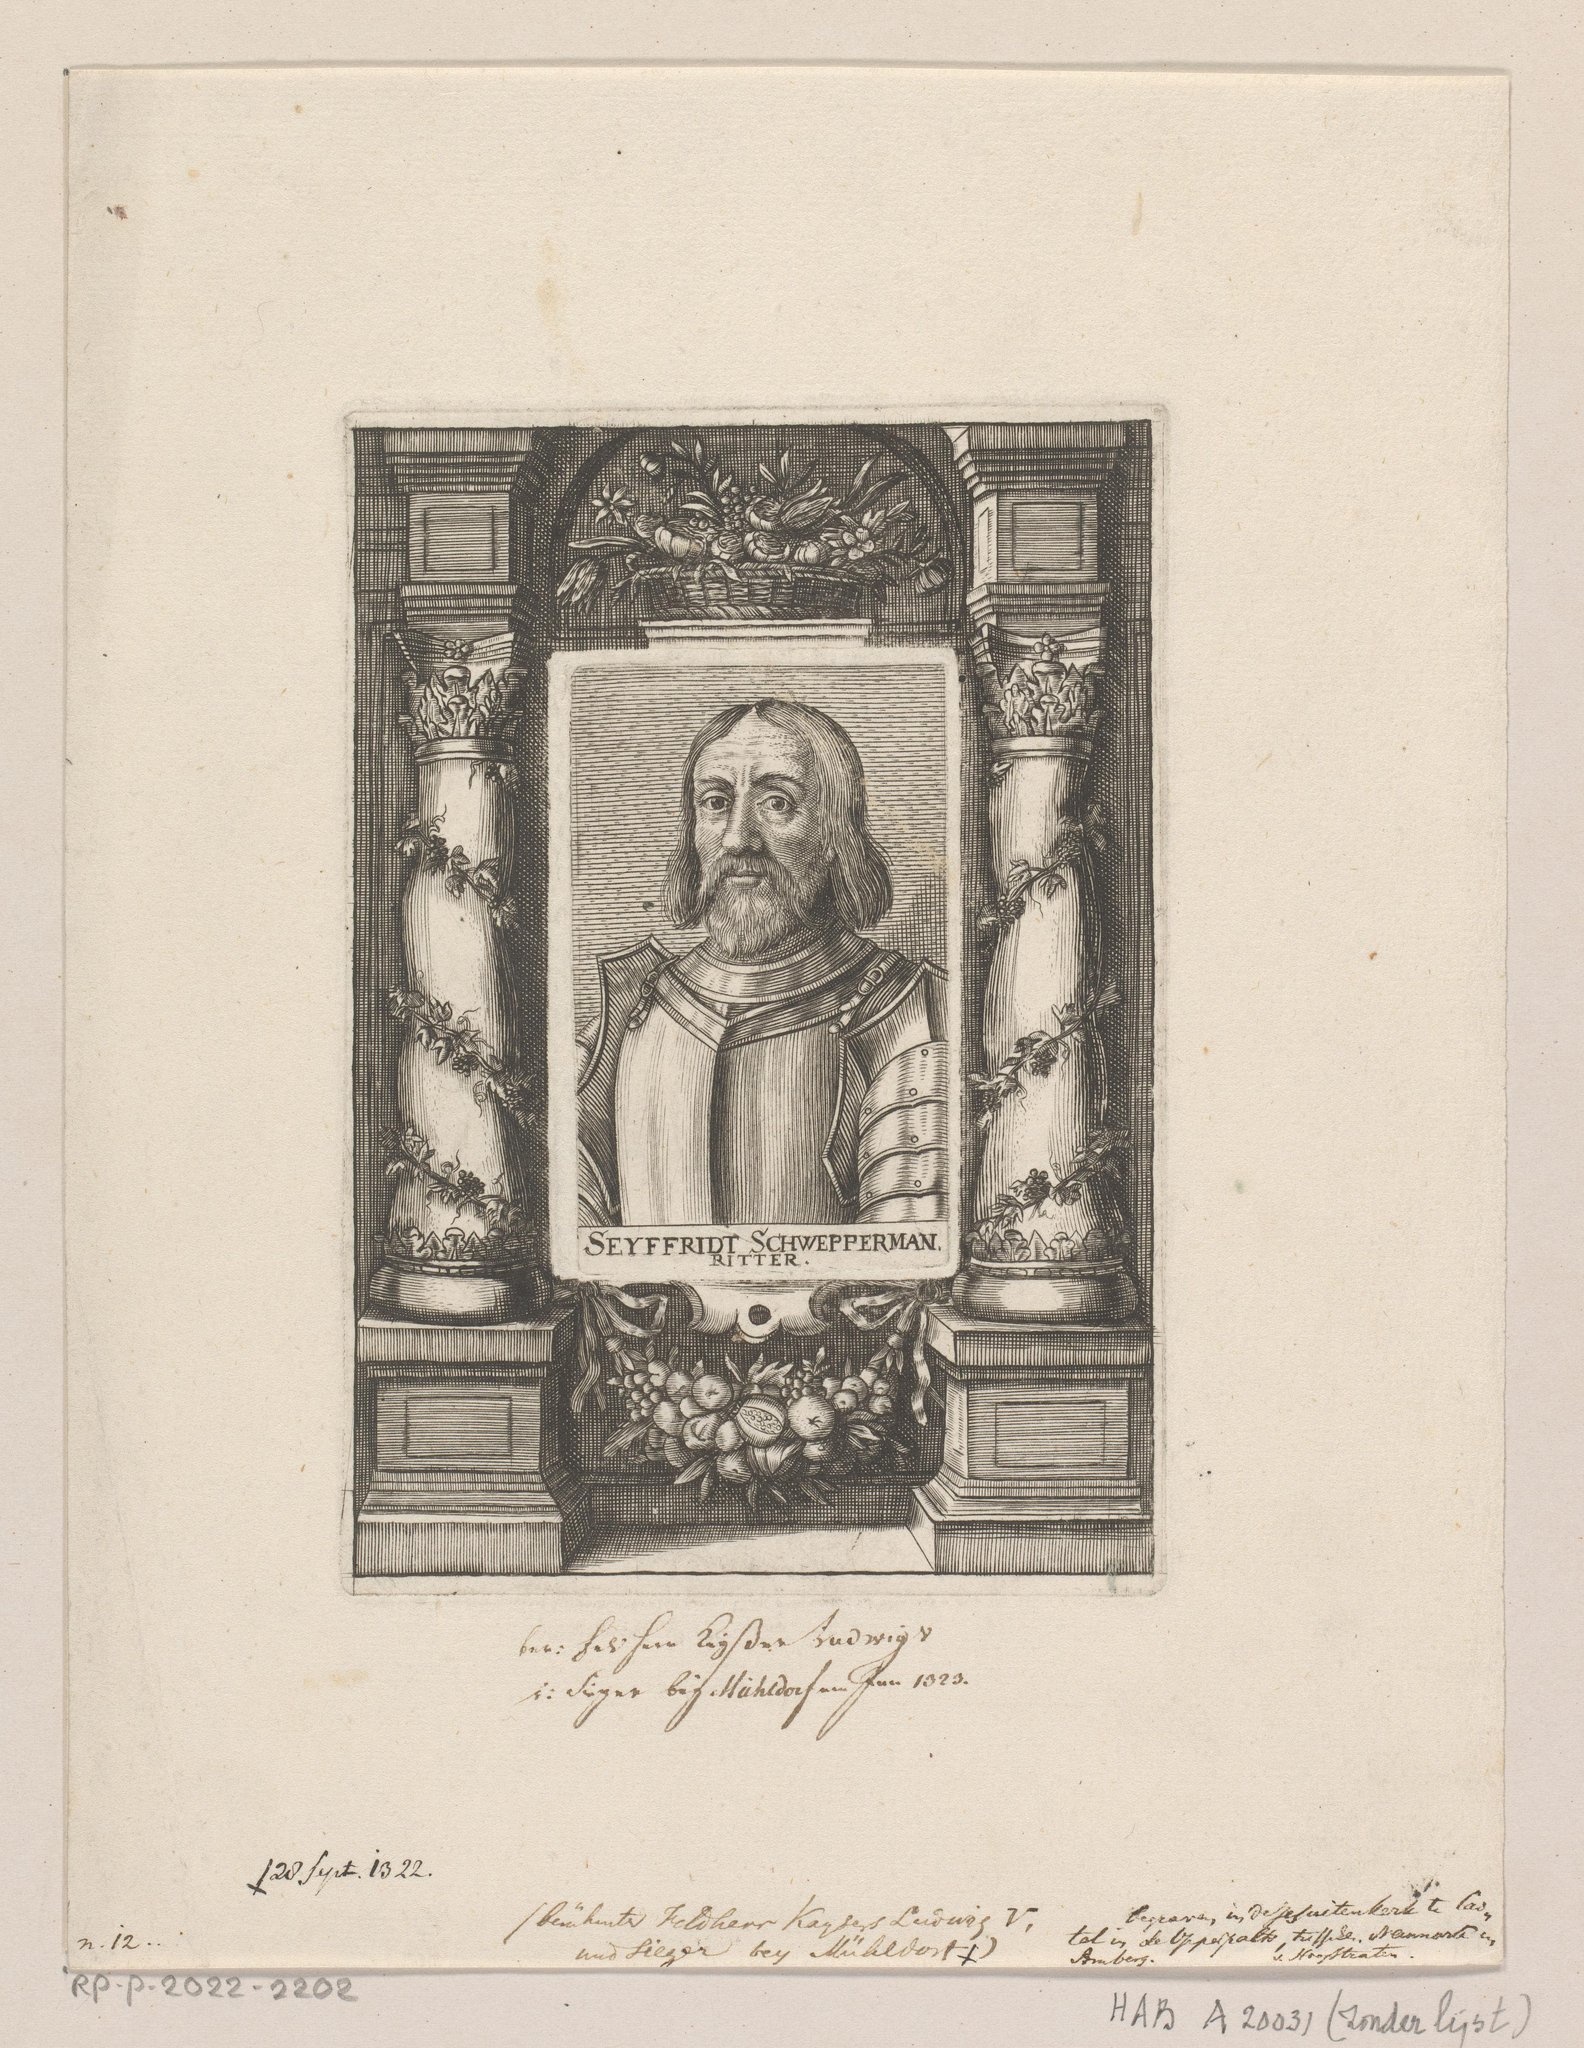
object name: print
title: Portret van Seyfried Schweppermann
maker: Anonymous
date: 1600-1699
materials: paper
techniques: engraving, etching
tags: commander-in-chief, general, marshal, historical persons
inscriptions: inscription: ‘[...] fus fur (...) [...]berg 's Hoogstraten.’